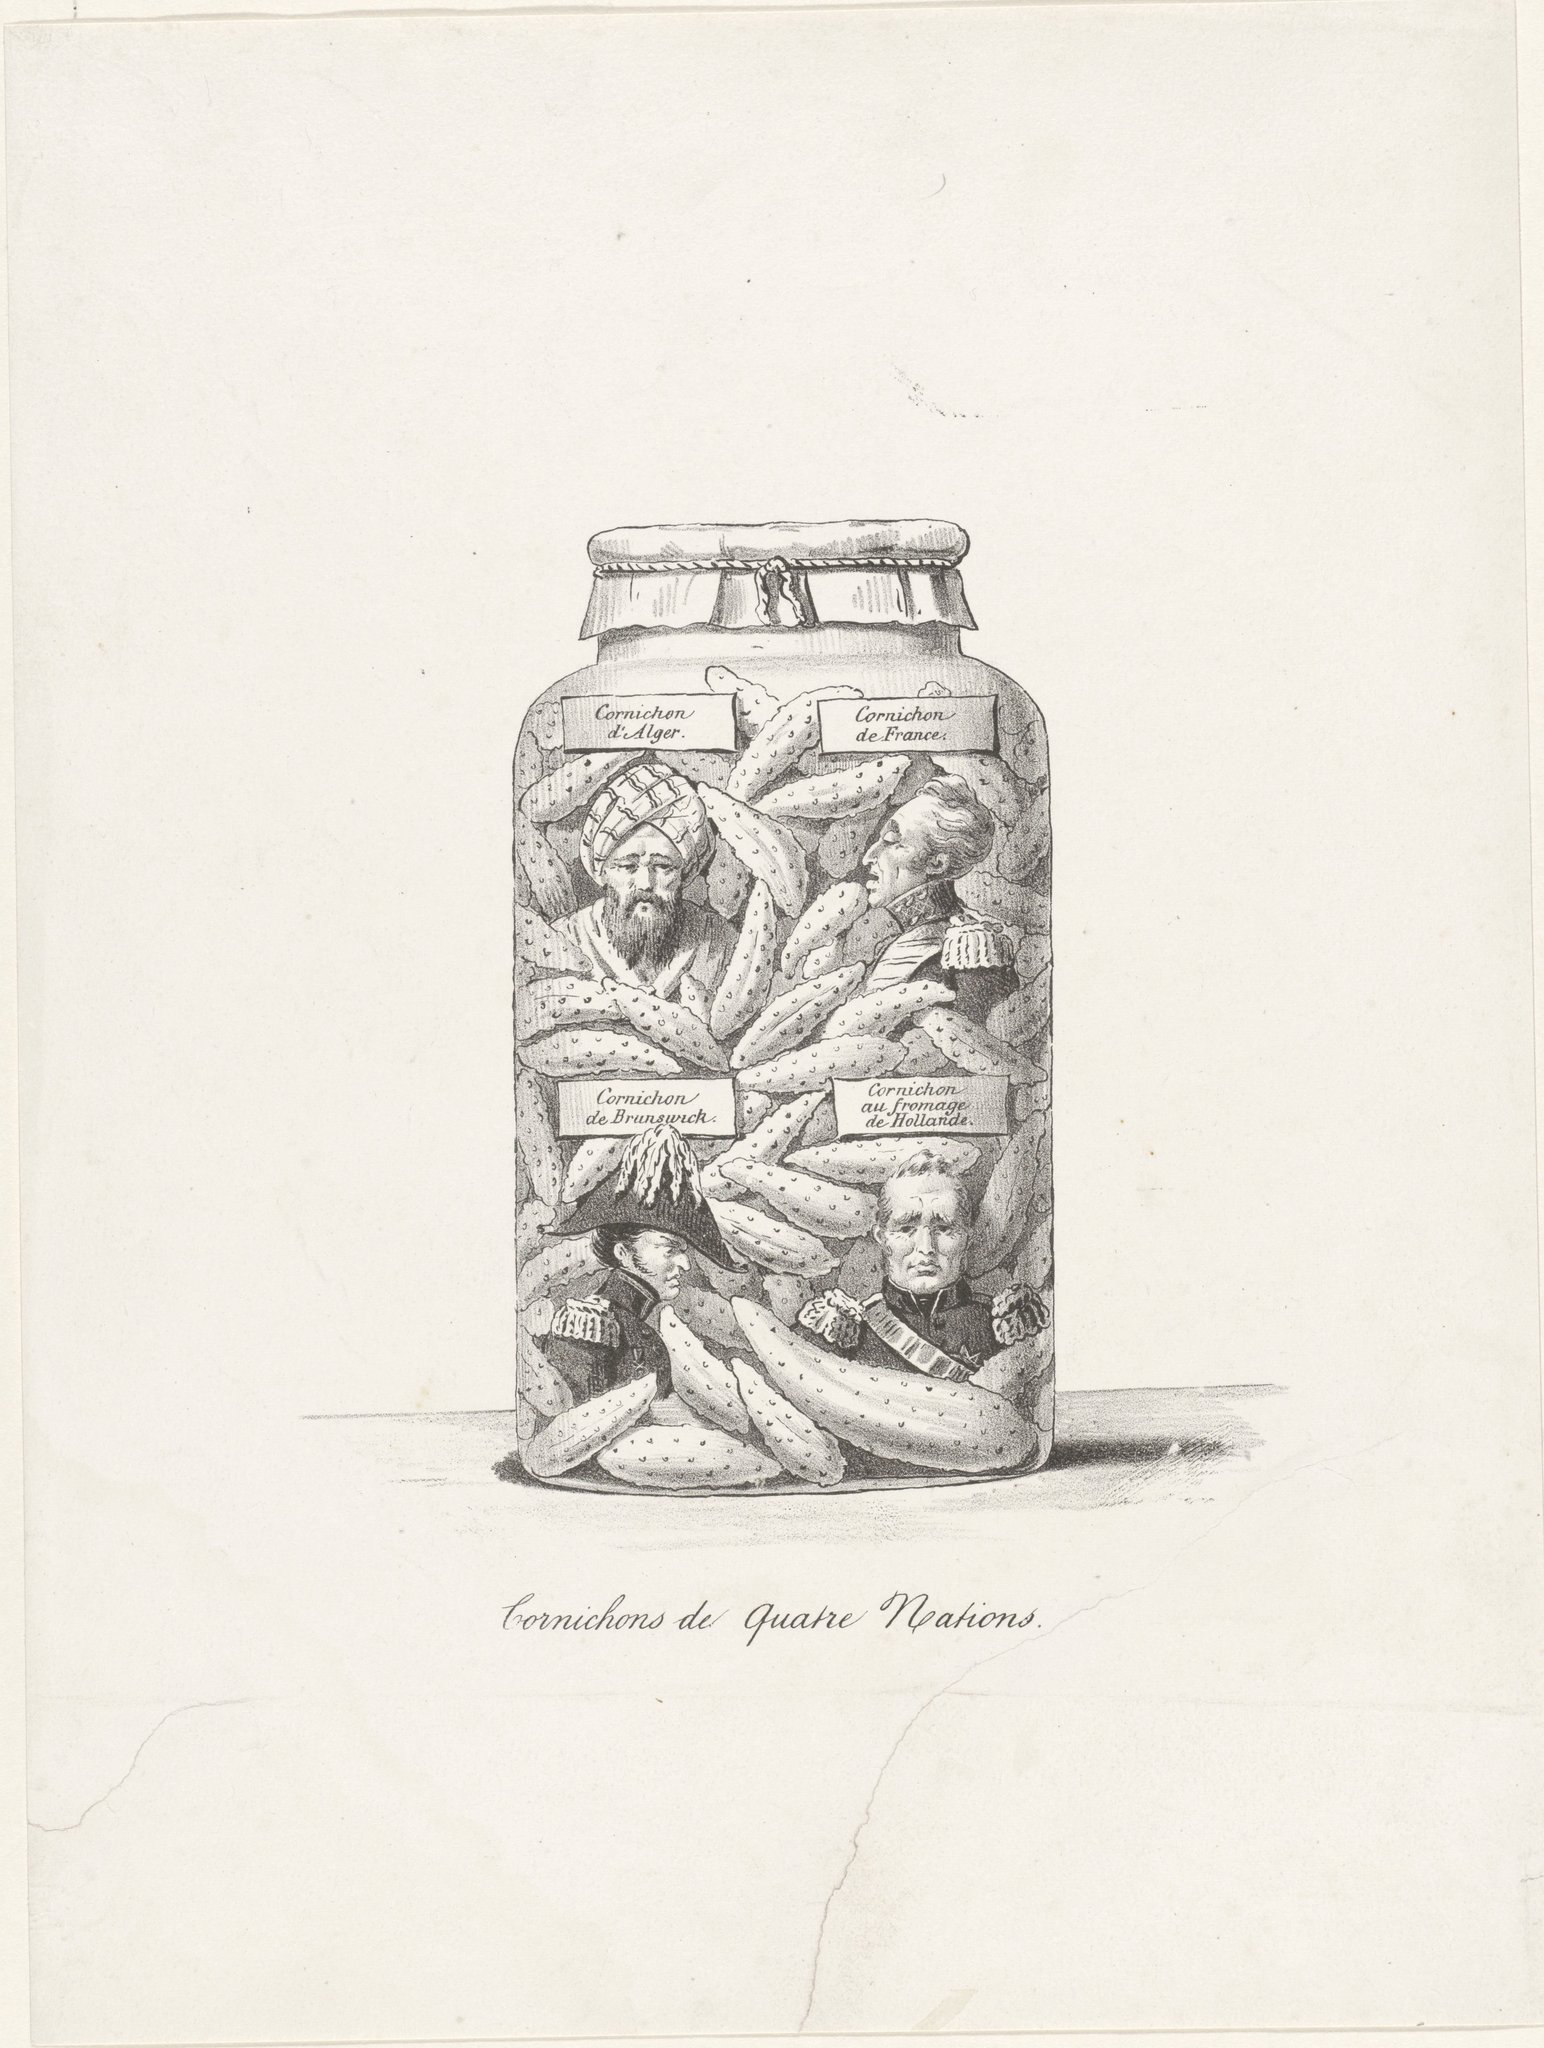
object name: cartoon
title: Augurken van vier naties, 1830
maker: Anonymous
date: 1830-1831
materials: paper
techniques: lithograph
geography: belgium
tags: berlin, william i of the netherlands, conserving, preserving, e.g.: canning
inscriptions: collector's mark: Lugt 2228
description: Spotprent op het Nederlands verlies van België, 1830. In een pot met augurken (cornichons) zitten in het zuur de vier in 1830 afgezette vorsten: koning Willem I 'Cornichon au fromage de Hollande', koning Karel X van Frankrijk, Anton, koning van Saksen en Hussein Dey van Algiers.